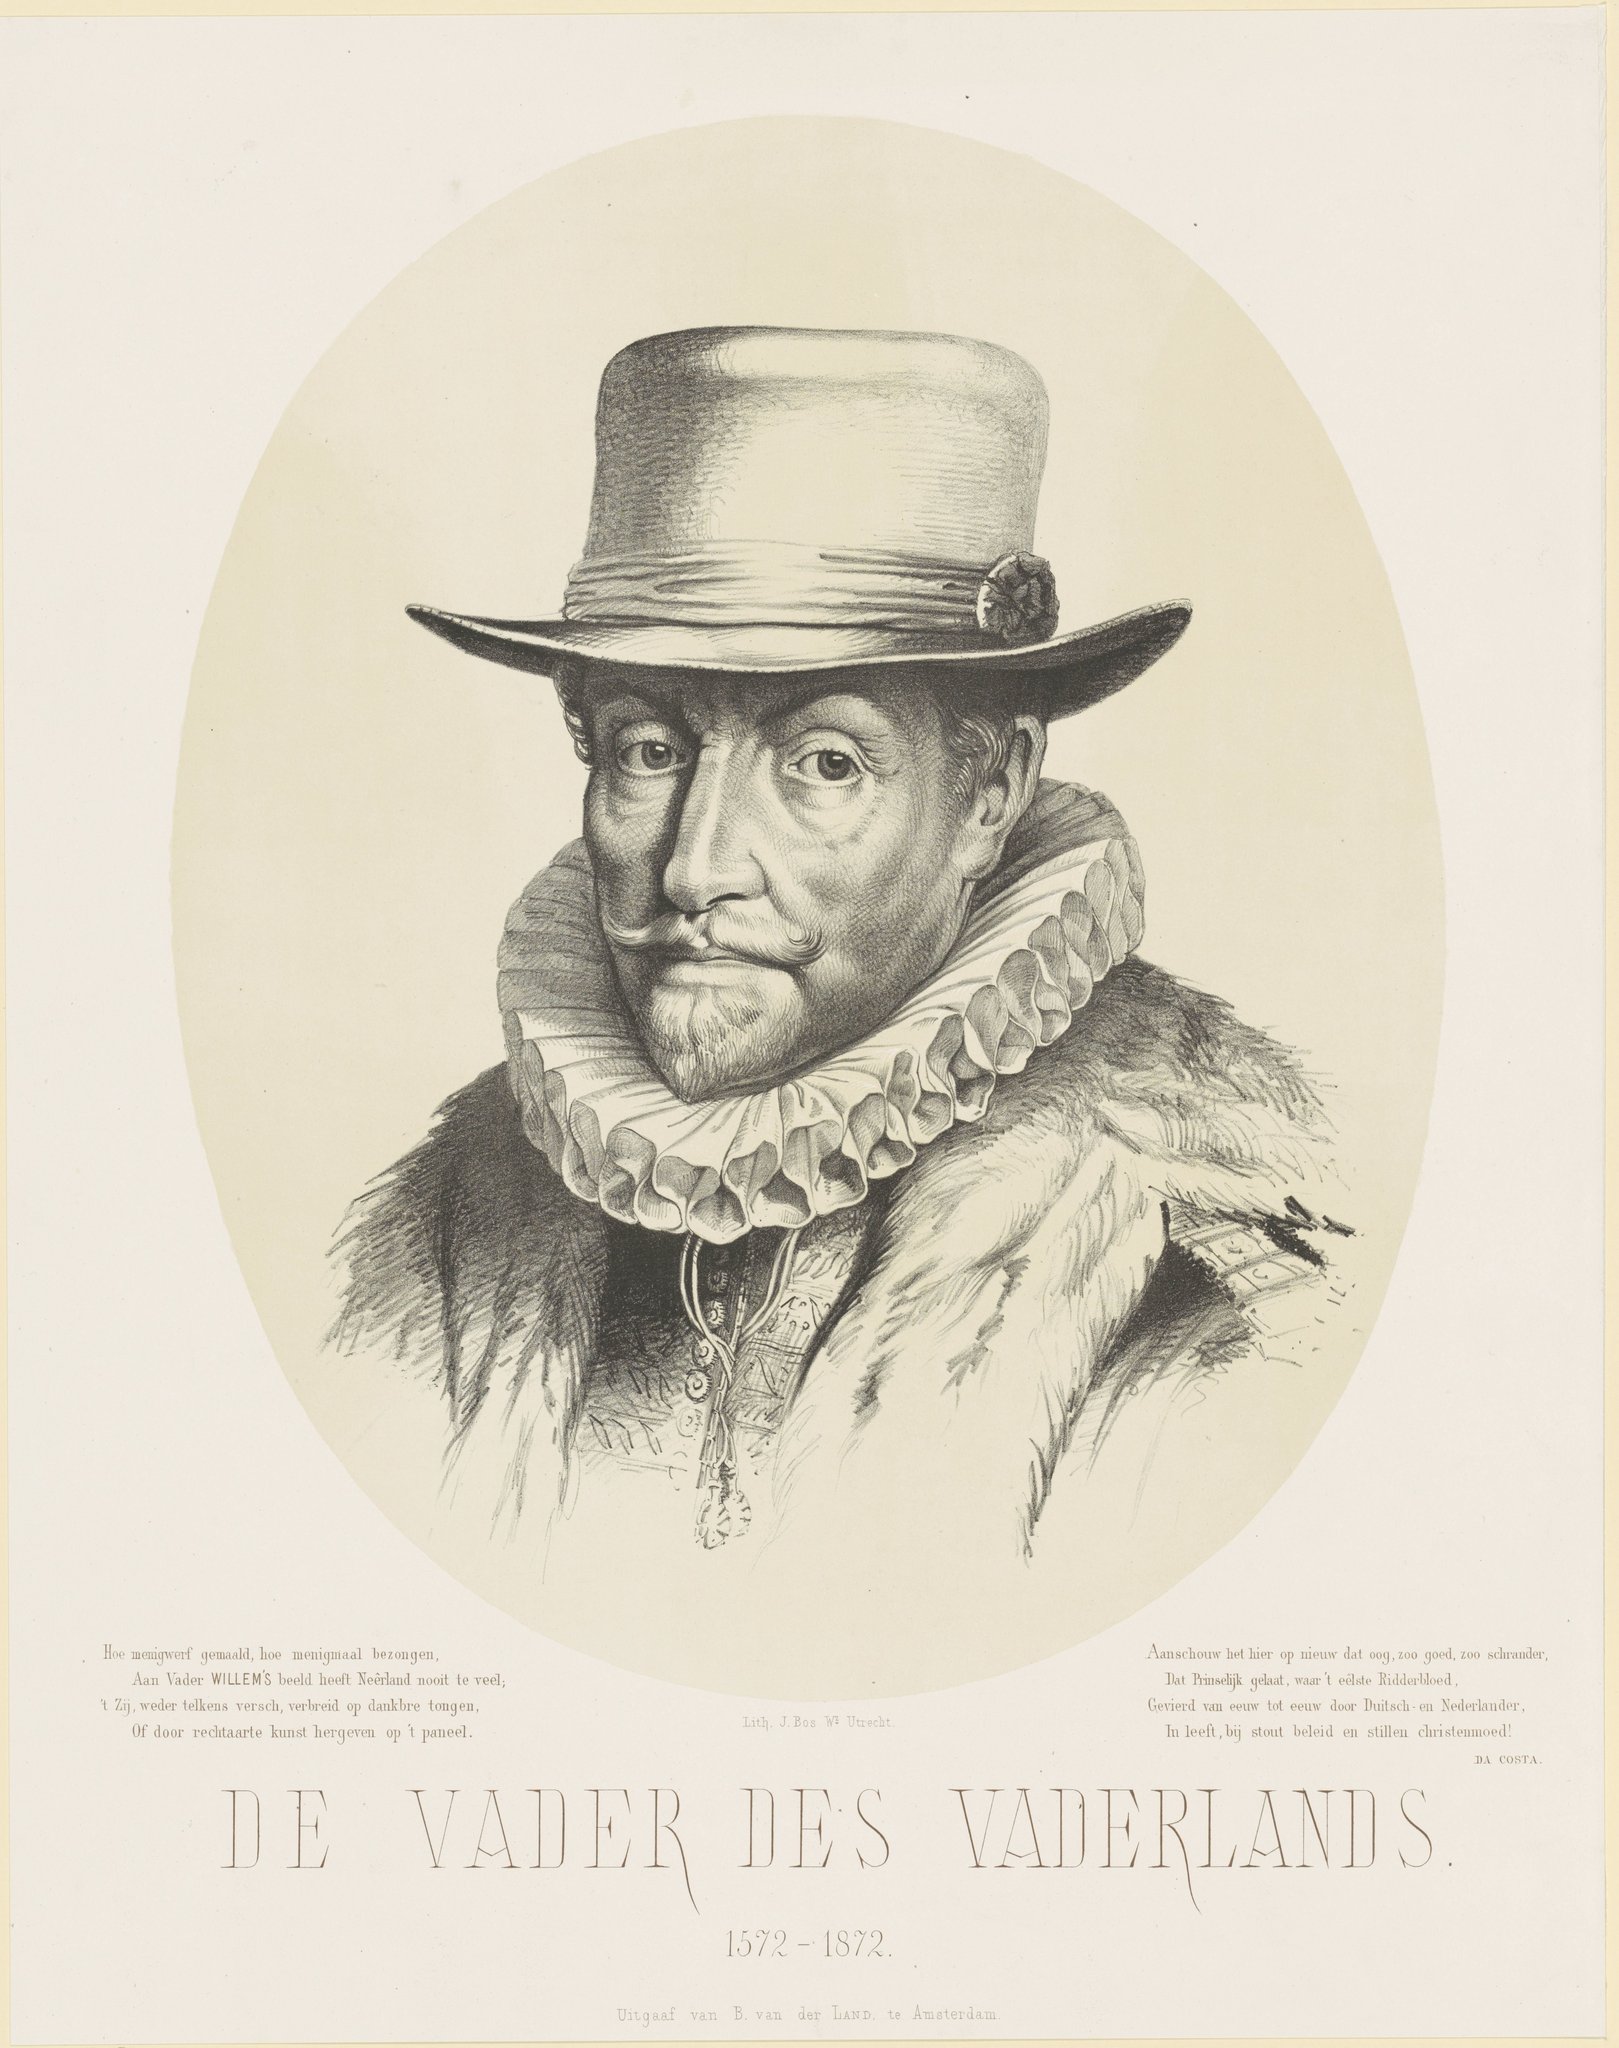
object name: print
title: Gedenkprent ter ere van Willem I, prins van Oranje, 1872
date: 1872-1874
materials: paper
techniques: lithograph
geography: netherlands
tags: delft, william i (prince of orange)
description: Gedenkprent ter ere van Willem I, 1872. Portret van Willem I met een hoed in een ovaal. Linksonder en rechtsonder een kolom met vier regels Nederlandse tekst. In de ondermarge twee regels Nederlandse tekst.